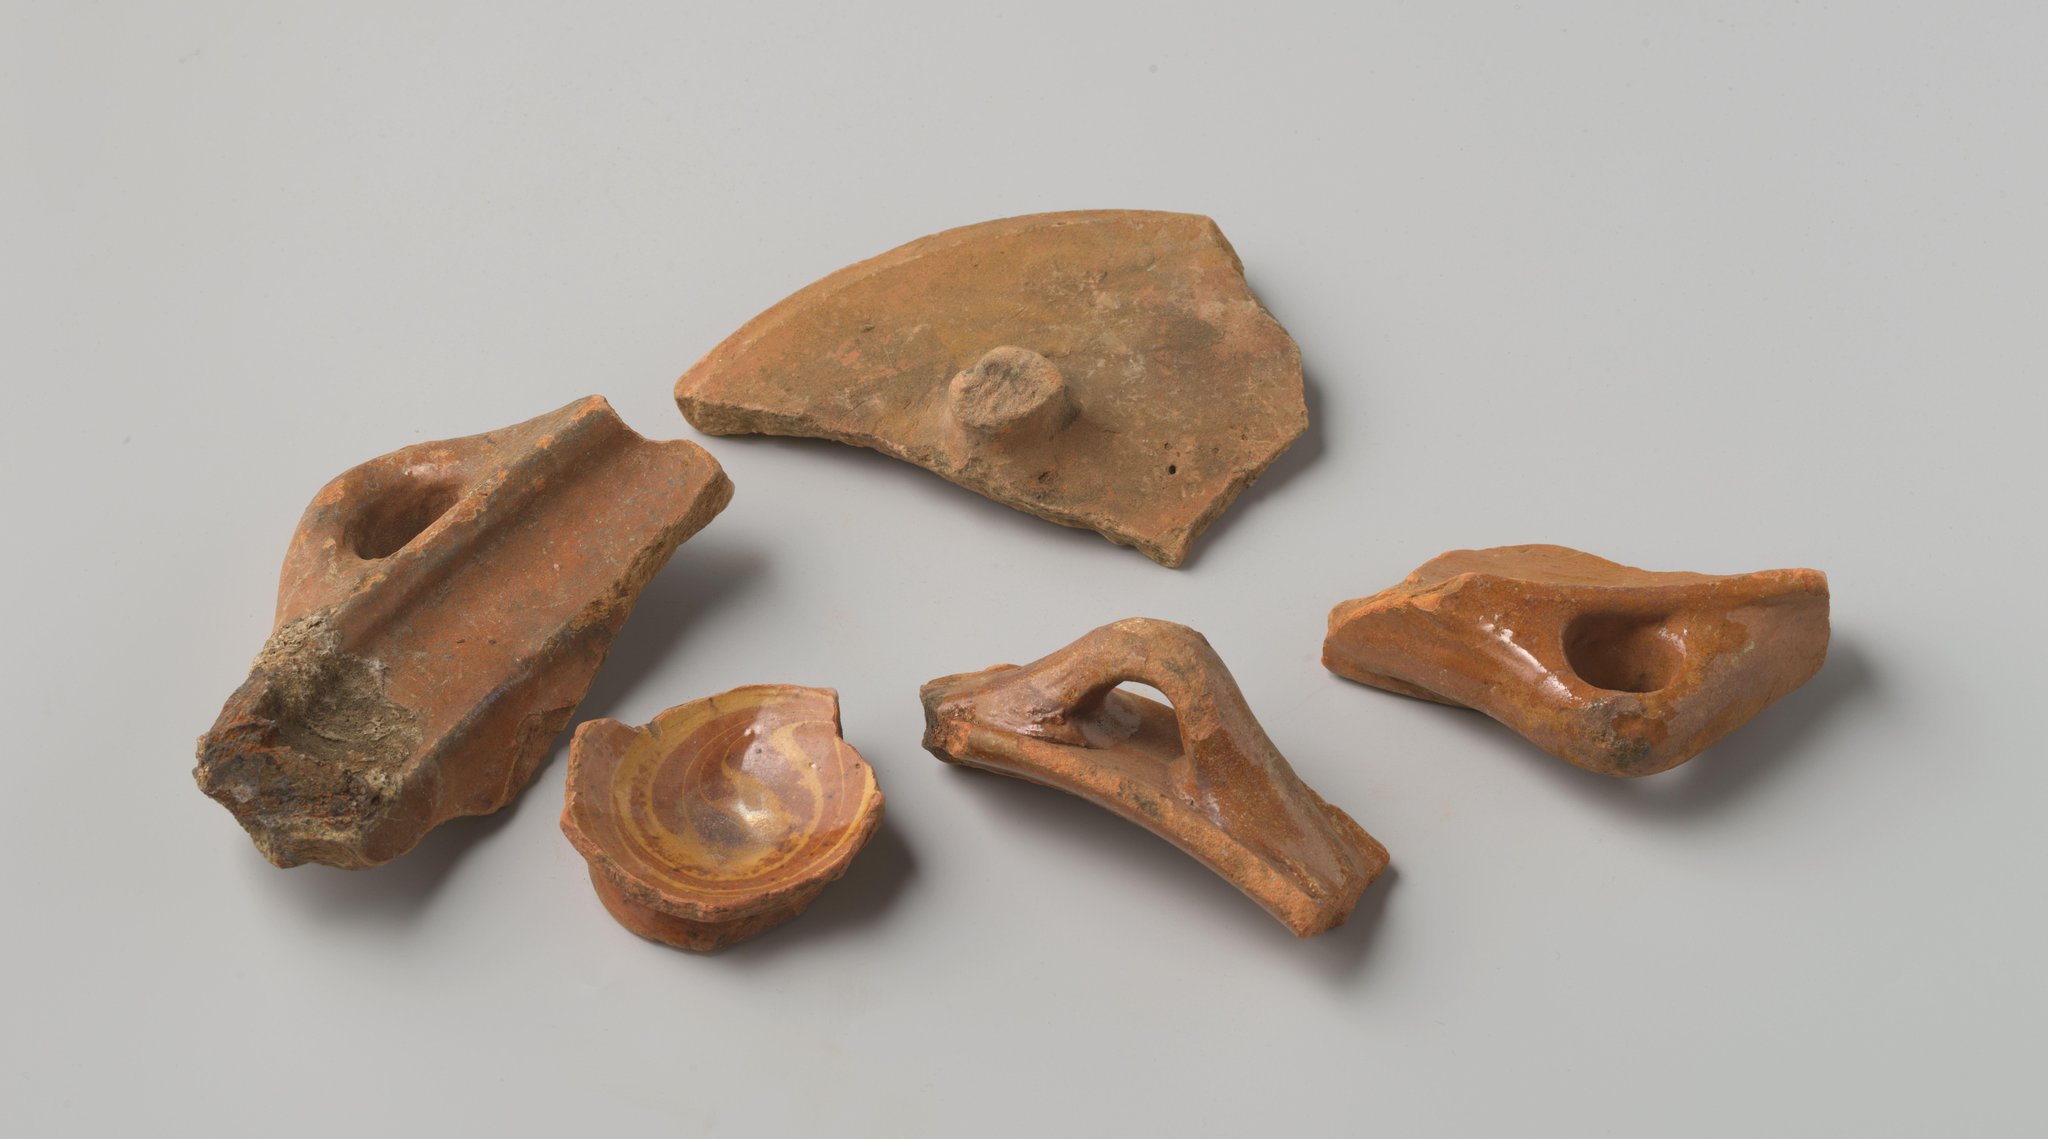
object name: sherd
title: Scherven aardewerk uit het wrak van de Oost-Indiëvaarder Hollandia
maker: Anonymous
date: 1700-1743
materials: earthenware, glaze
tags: verenigde oostindische compagnie, hollandia (schip), annet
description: Scherven roodbakkend aardewerk met glazuur.